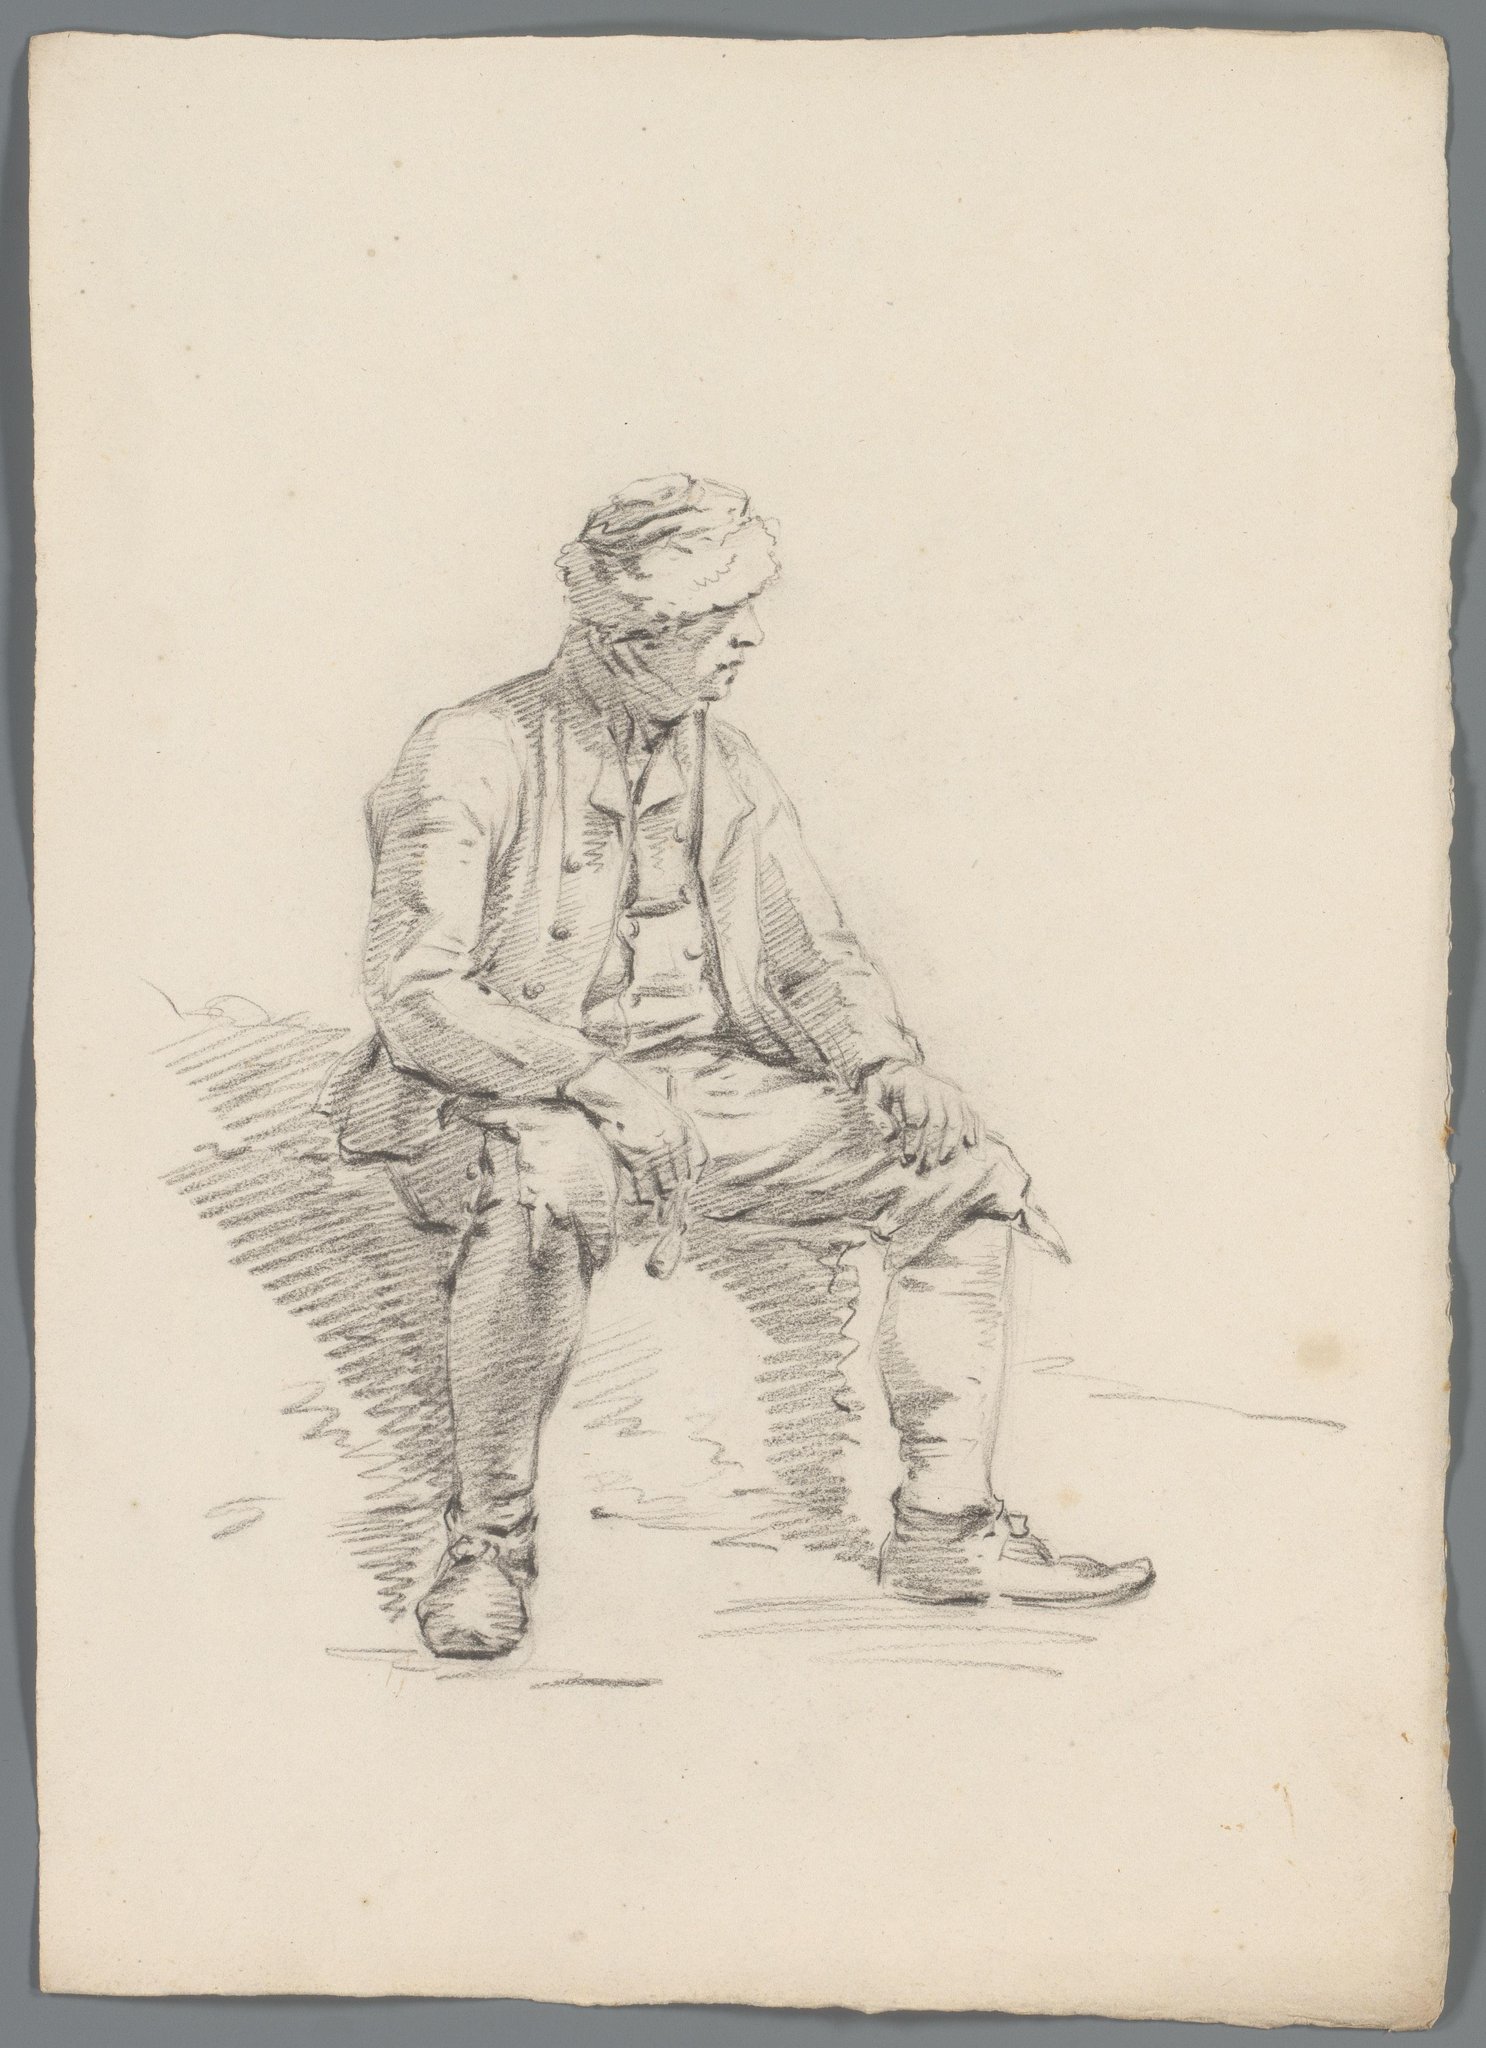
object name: drawing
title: Zittende man met pijp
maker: Anonymous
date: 1820-1830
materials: chalk, paper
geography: the hague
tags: sitting figure, adult man, pipe ~ tobacco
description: Tekeningen waarschijnlijk ontstaan bij het Haagse kunstgenootschap ‘Tot Nut der Tekenkunst’, waar twee keer per week tekenavonden werden georganiseerd met geklede modellen.